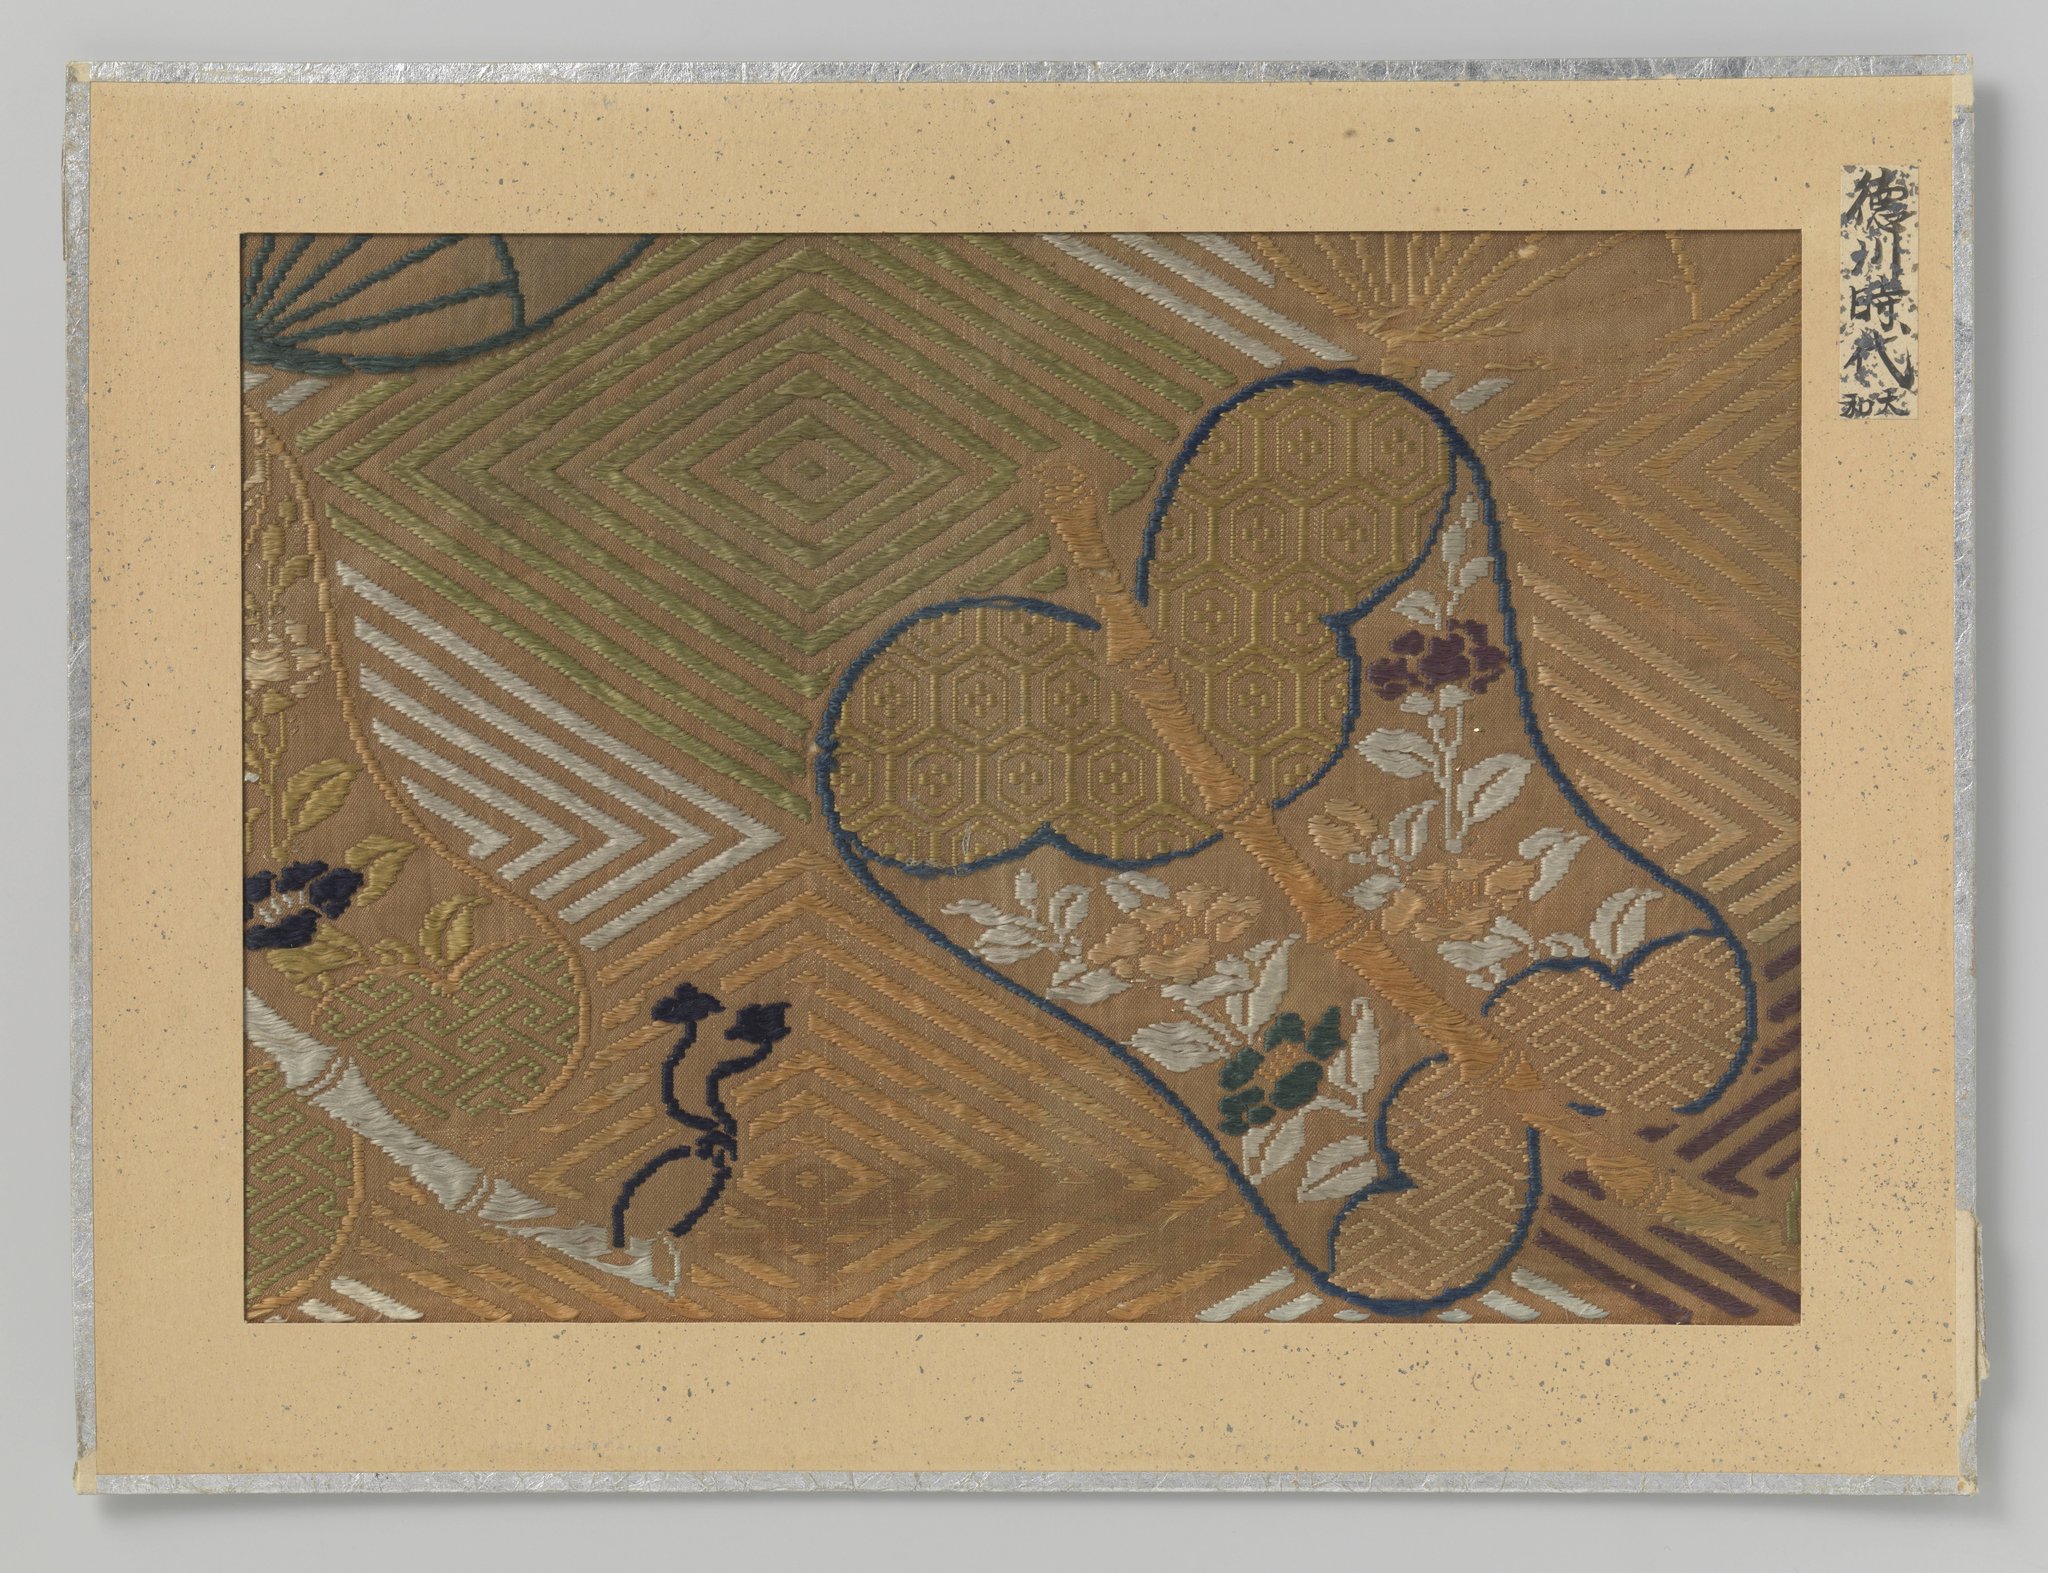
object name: fragment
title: Fragment textiel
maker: Anonymous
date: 1681-1684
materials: silk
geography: japan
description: Textielfragment, versiering waaier en geometrische motieven op een bruin fond.